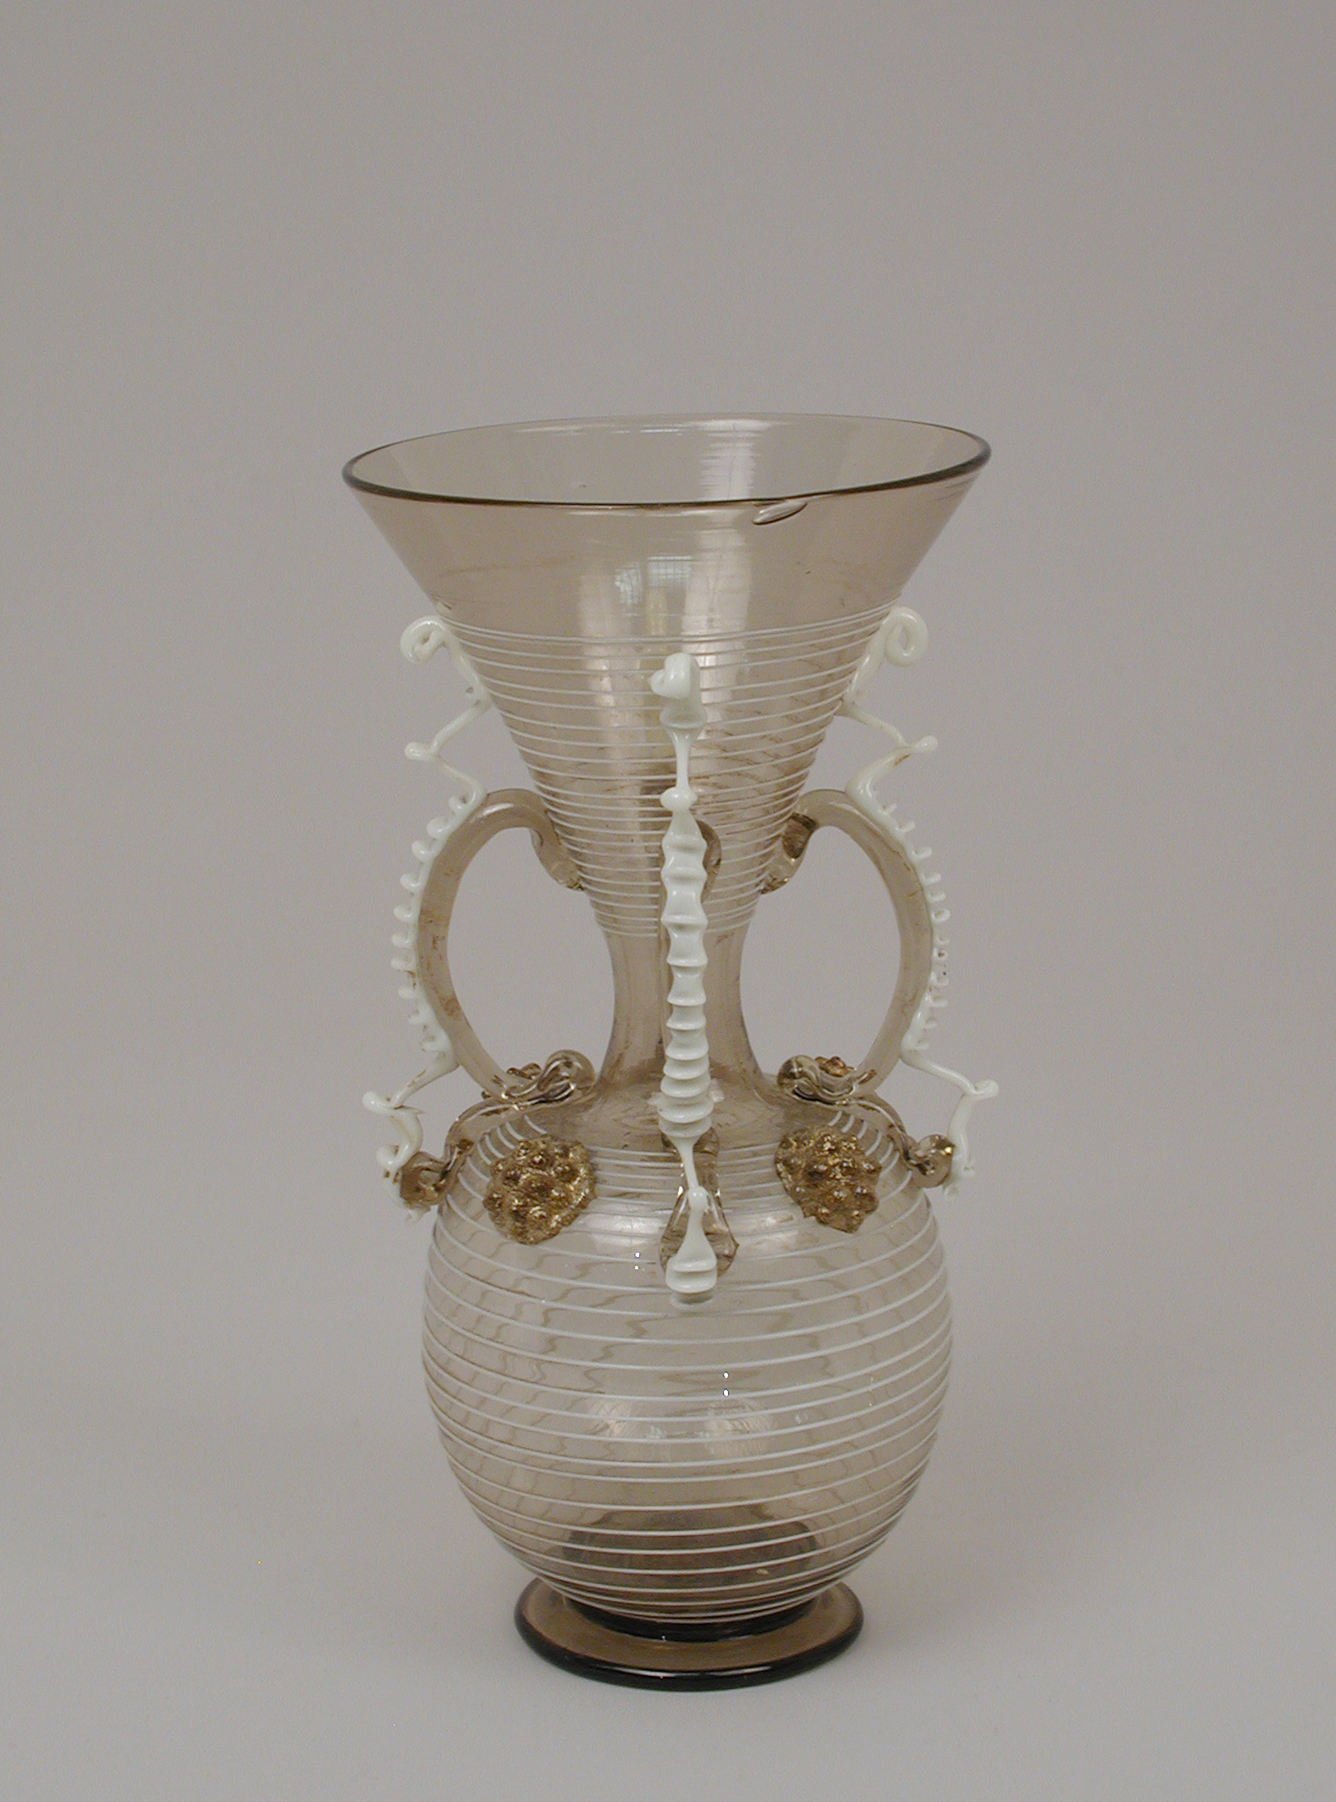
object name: vase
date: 1801-1900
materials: glass